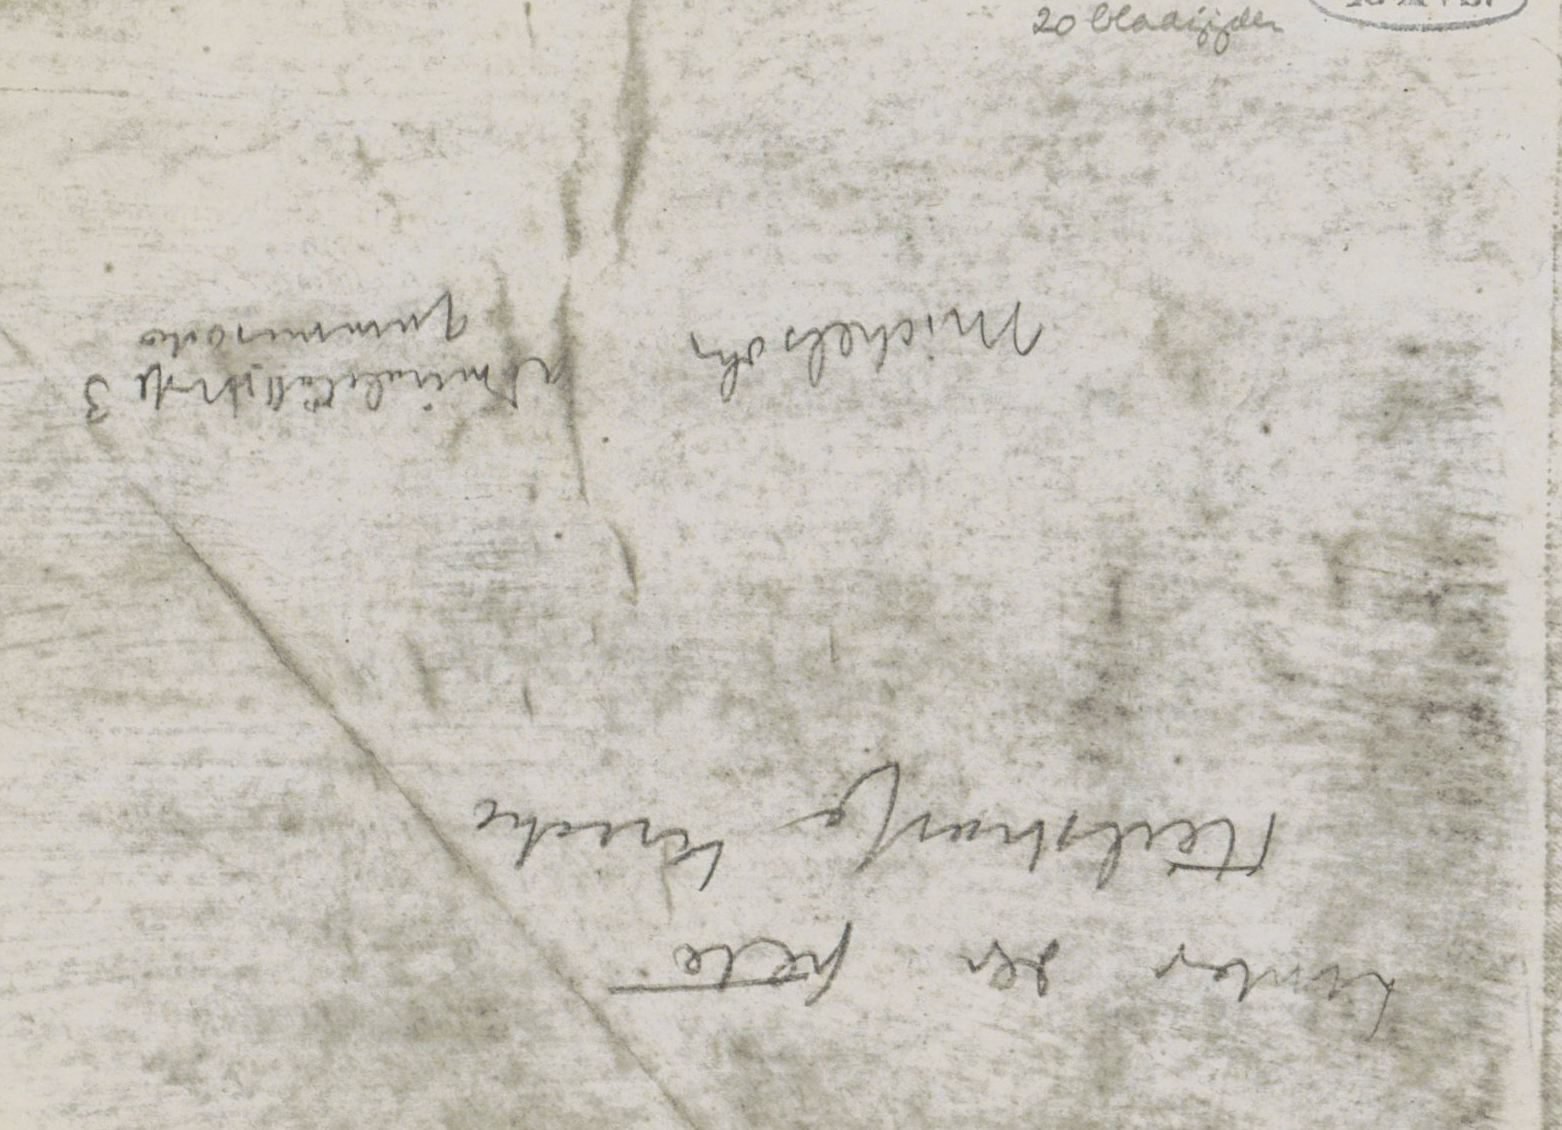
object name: sketchbook leaf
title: Annotaties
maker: isaac israels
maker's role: draughtsman, painter, print maker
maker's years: 1865-1934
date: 1875-1934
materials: paper, pencil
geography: amsterdam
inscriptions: annotation: ‘hinter der alte / Heilstrasse Kirche[?] / Michelsohn / Admiralitätsstrasse 3 / [...]’, collector's mark: Lugt 2228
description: Schutblad A, voorste schutblad, uit schetsboek XXXI met 10 bladen.